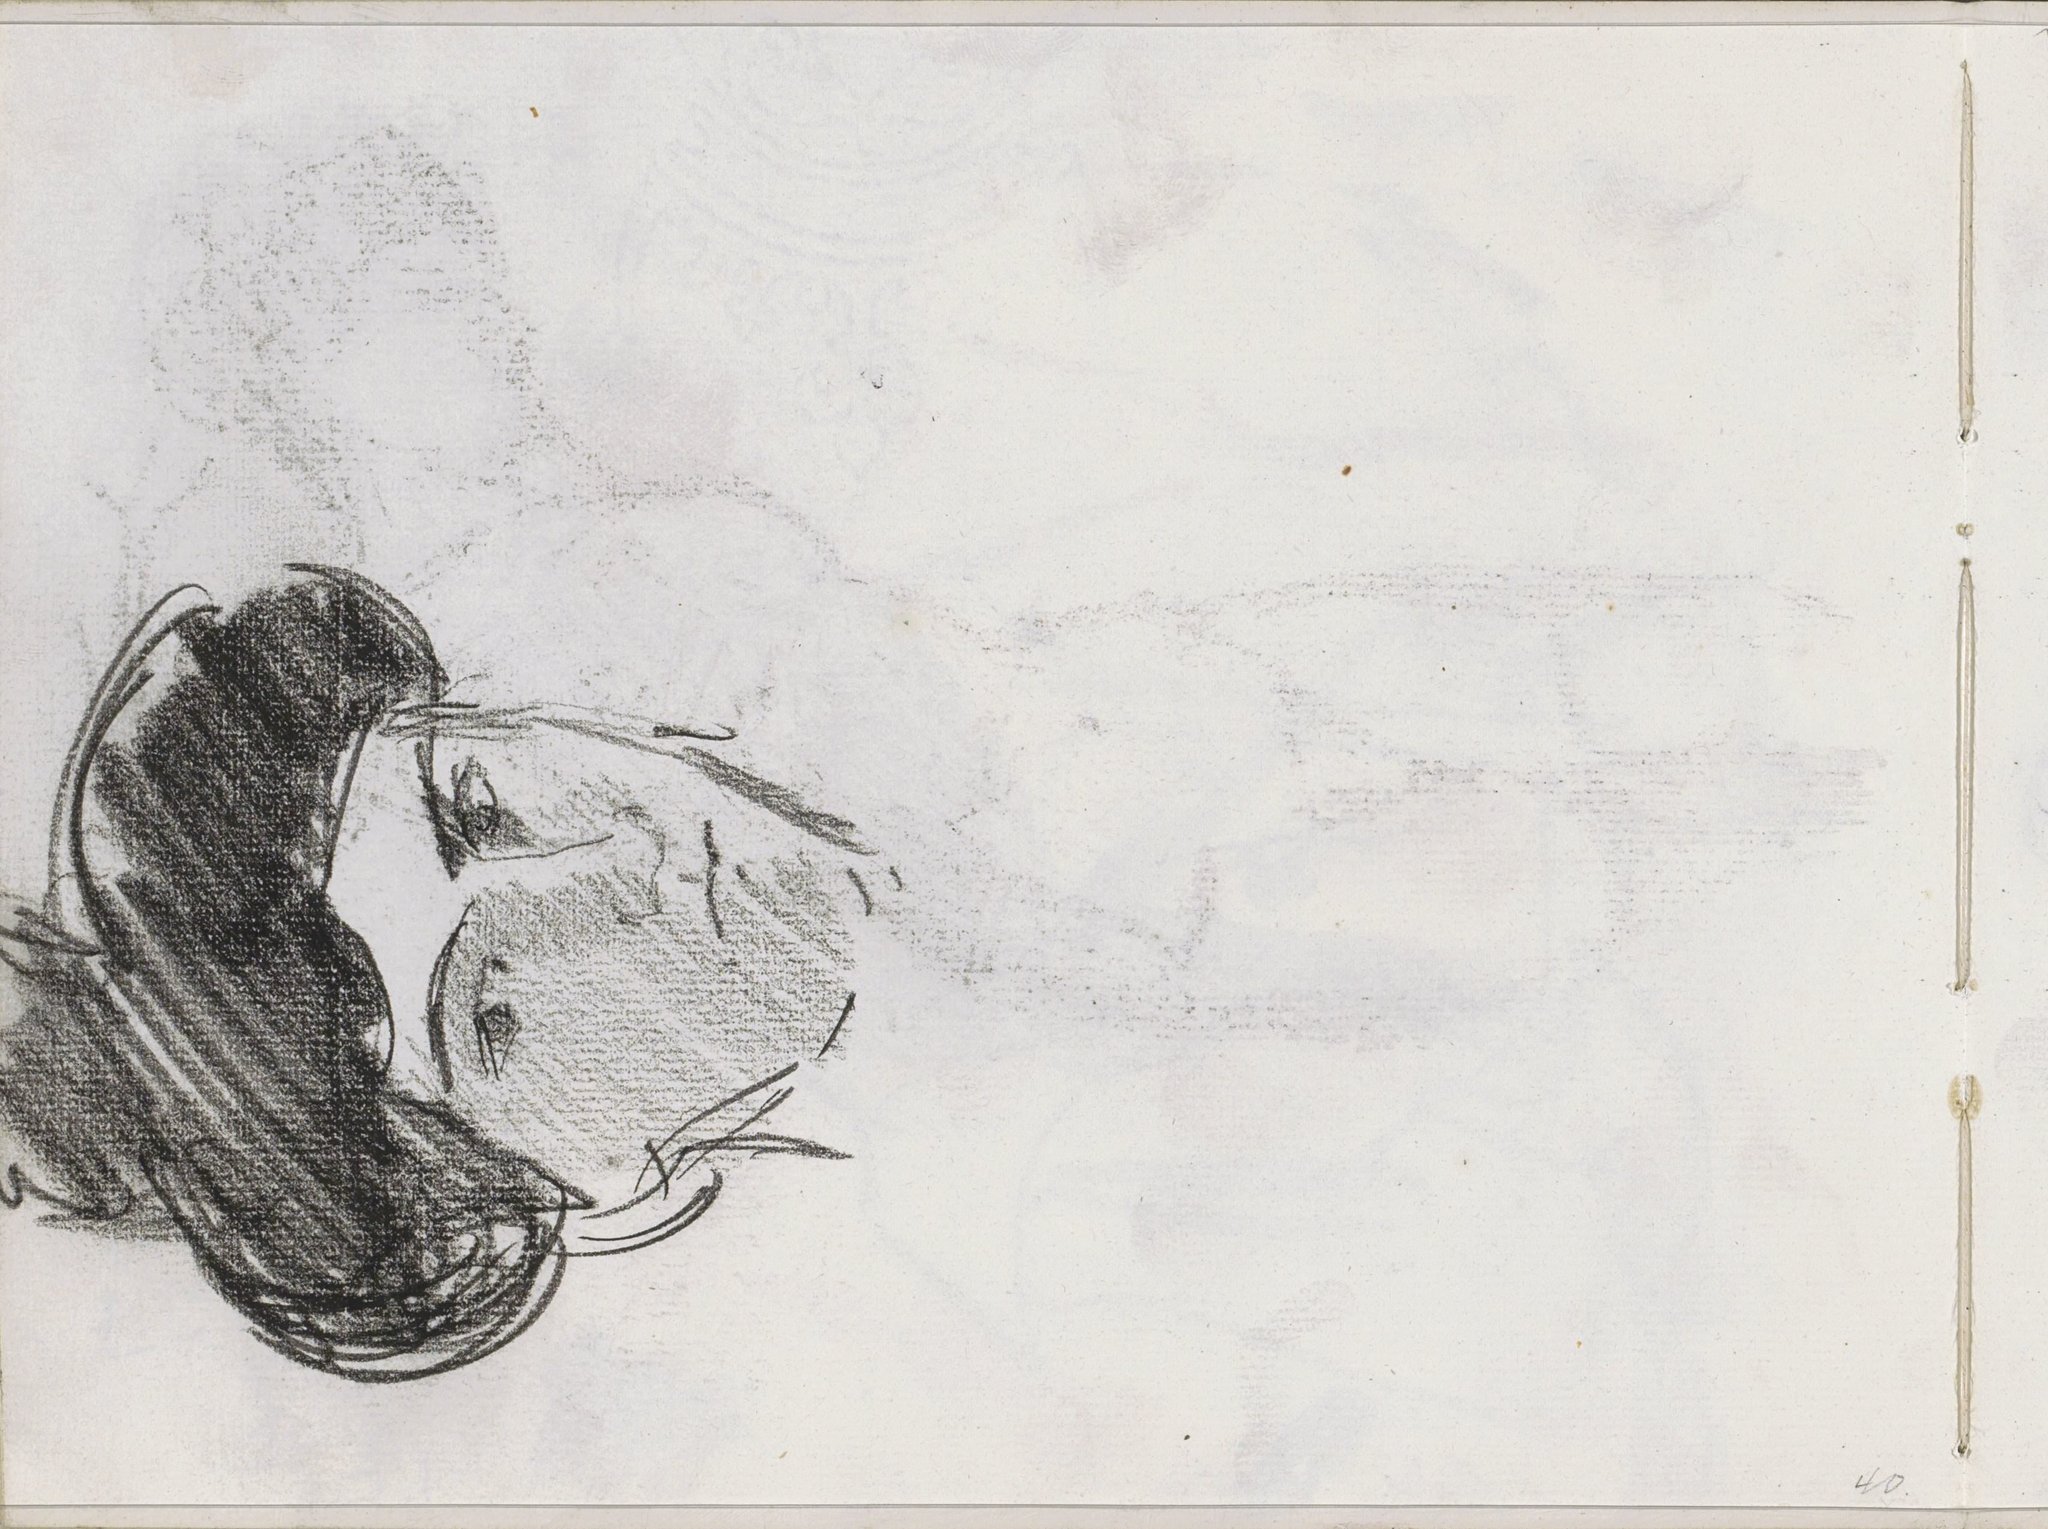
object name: sketchbook leaf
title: Vrouwenhoofd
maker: isaac israels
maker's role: draughtsman, painter, print maker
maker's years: 1865-1934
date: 1875-1934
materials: chalk, paper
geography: the hague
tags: head (human) - aa - female human figure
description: Blad 9 verso uit schetsboek XXII met 30 bladen.